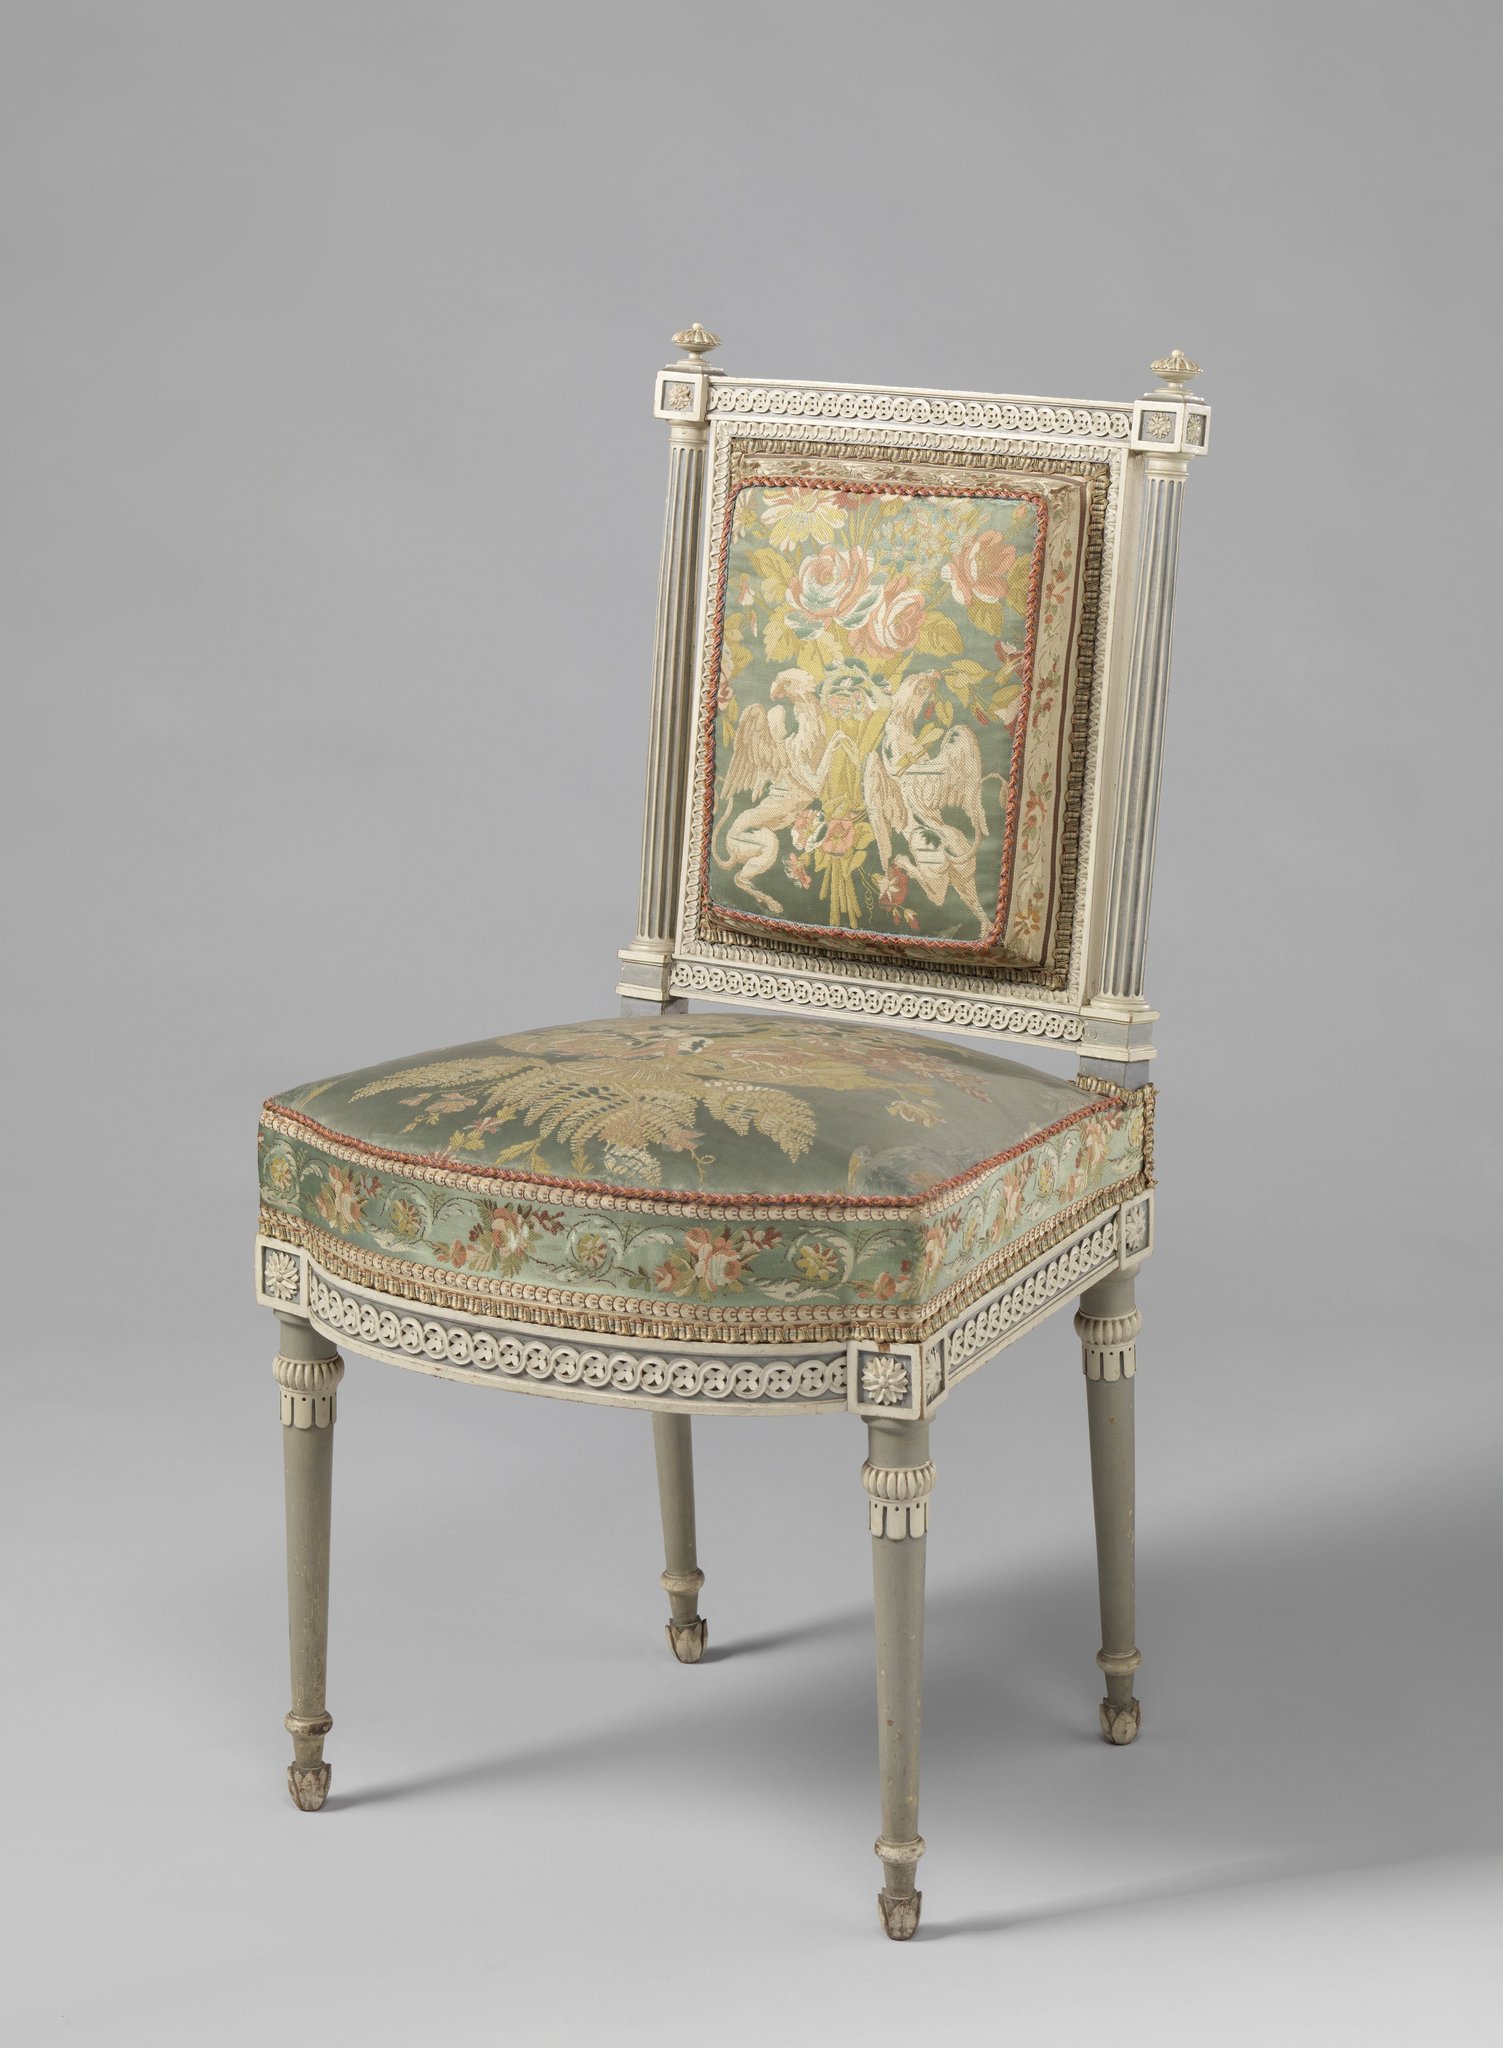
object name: chair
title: Stoel Kops-ameublement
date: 1793-1795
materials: wood, paint, silk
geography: netherlands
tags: haarlem, griffin (lion/eagle); 'griffo' (ripa), flowers ~ ornament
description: Beklede stoel, deel uitmakend van het Kops-ameublement, van wit en blauwgrijs beschilderd beukenhout en rustend op conische poten. De zitregels en dorpels van het rugraam, met Toscaanse gecanneleerde zuilen als rugstijlen, vertonen gestoken vlechtband met rozetten. Afwerking met rozetten en acanthusbladeren. De bekleding vertoont op lichtblauwe satijnen grond florale motieven, op de rug gehouden door griffioenen. Besteld voor het pand Nieuwe Gracht 74, Haarlem. Zie: BK-15615-a/p, BK-15614, BK-15616-a/b.